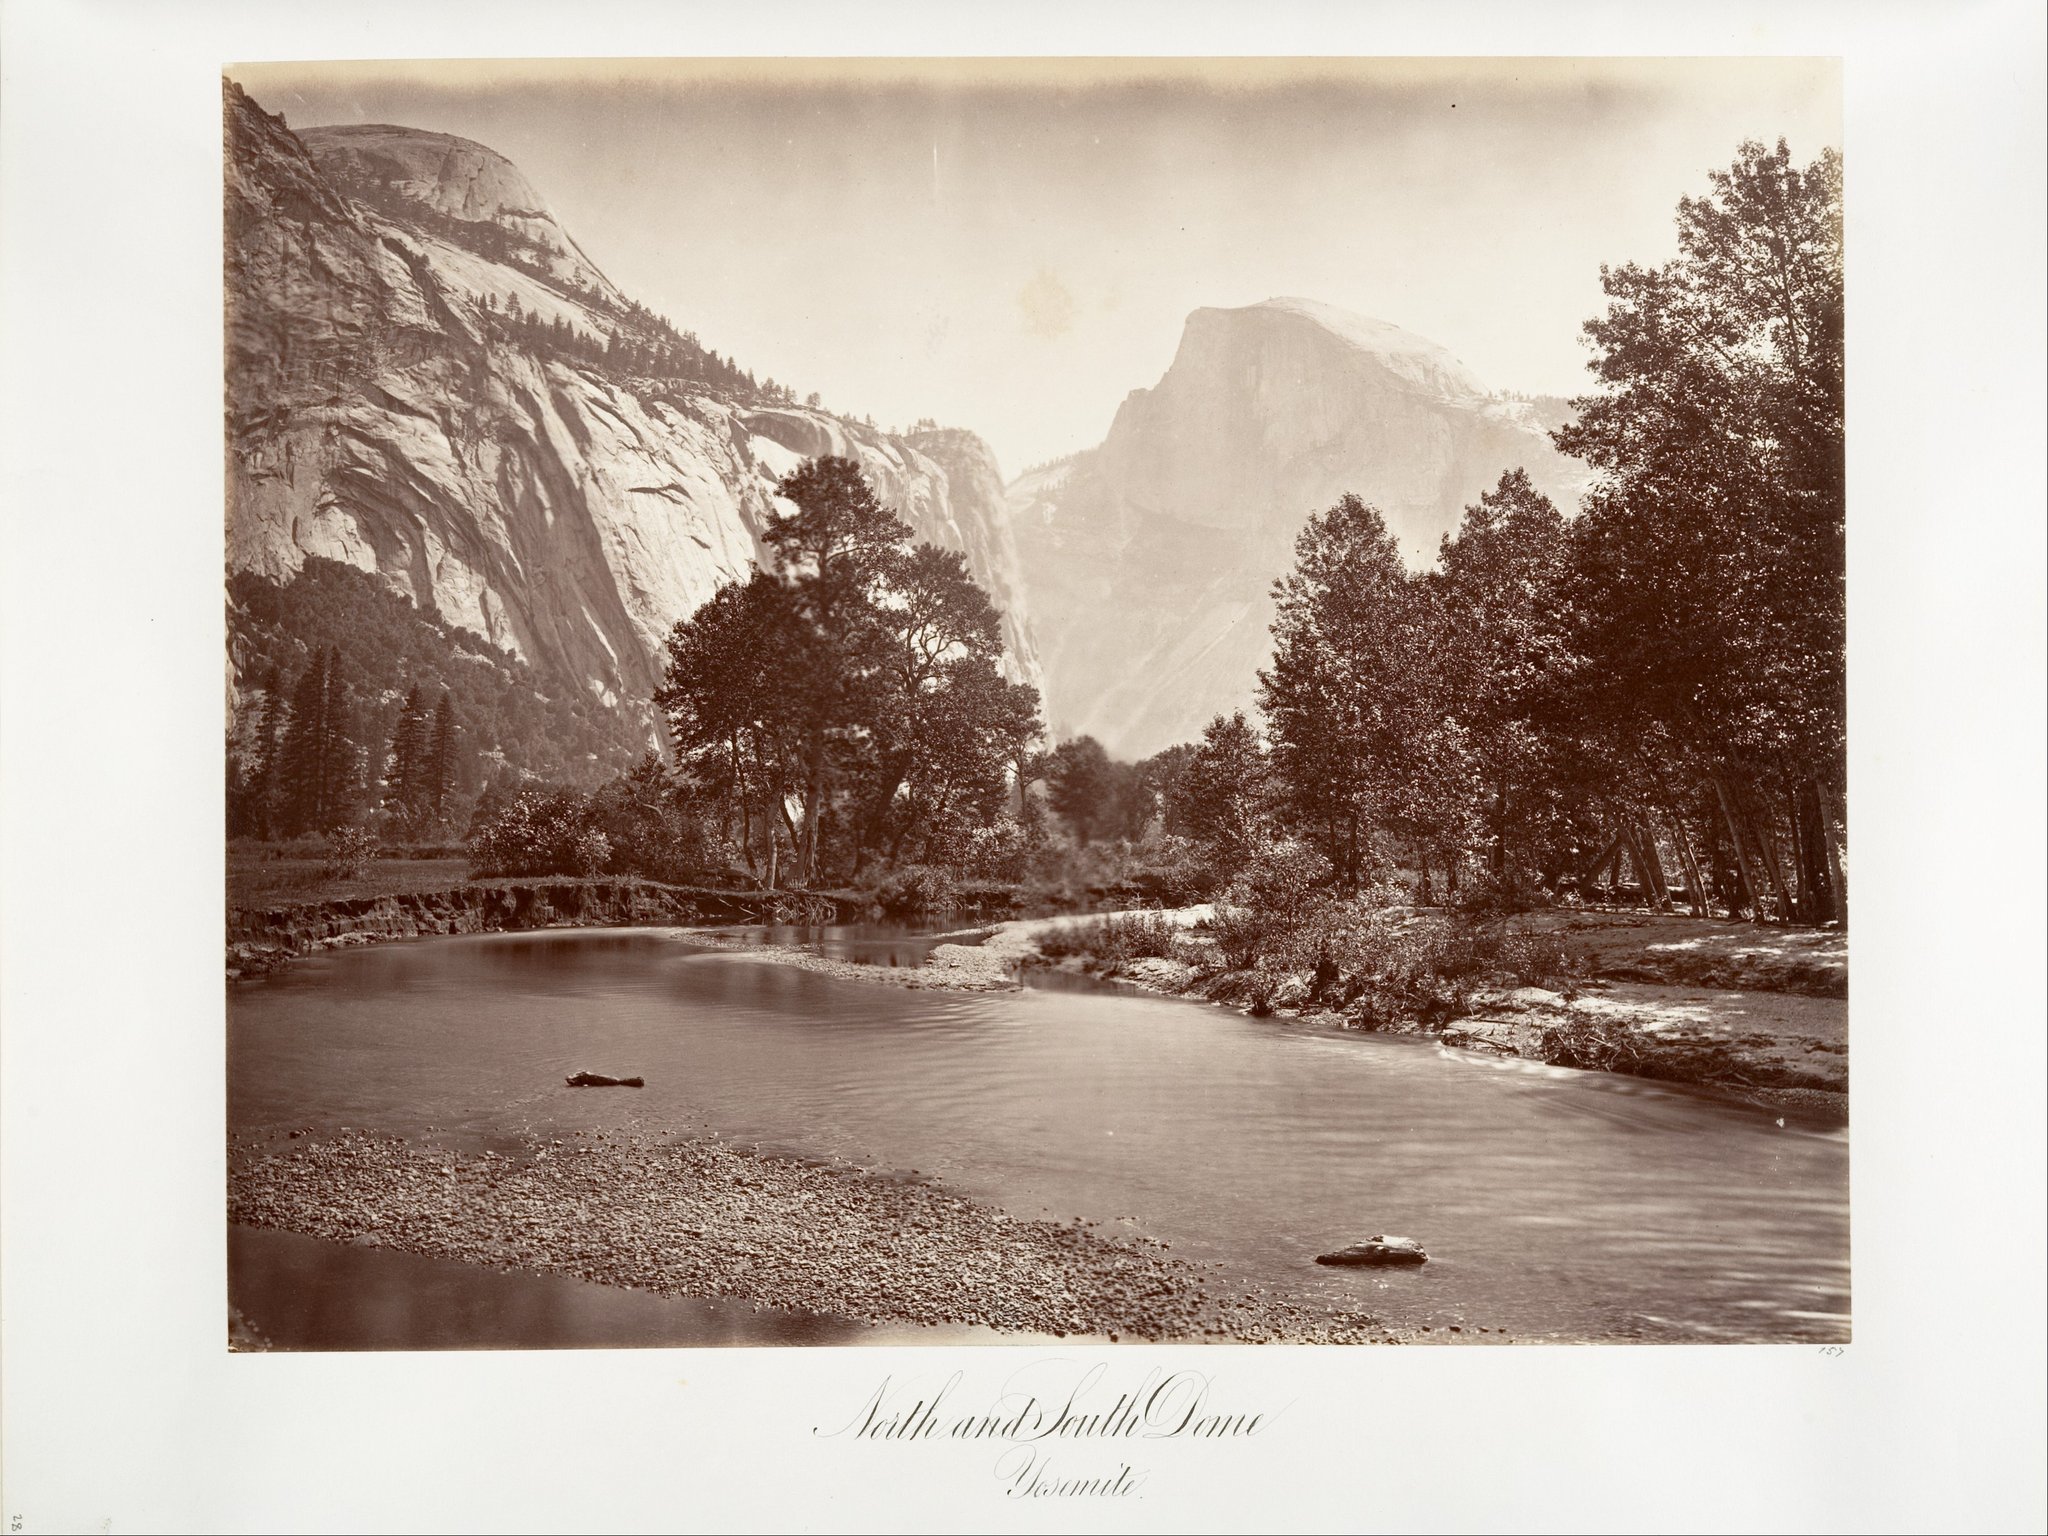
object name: photograph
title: North and South Dome, Yosemite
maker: carleton e. watkins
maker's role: artist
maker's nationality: american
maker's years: 1829-1916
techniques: albumen silver print, glass negative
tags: rivers,mountains,landscapes